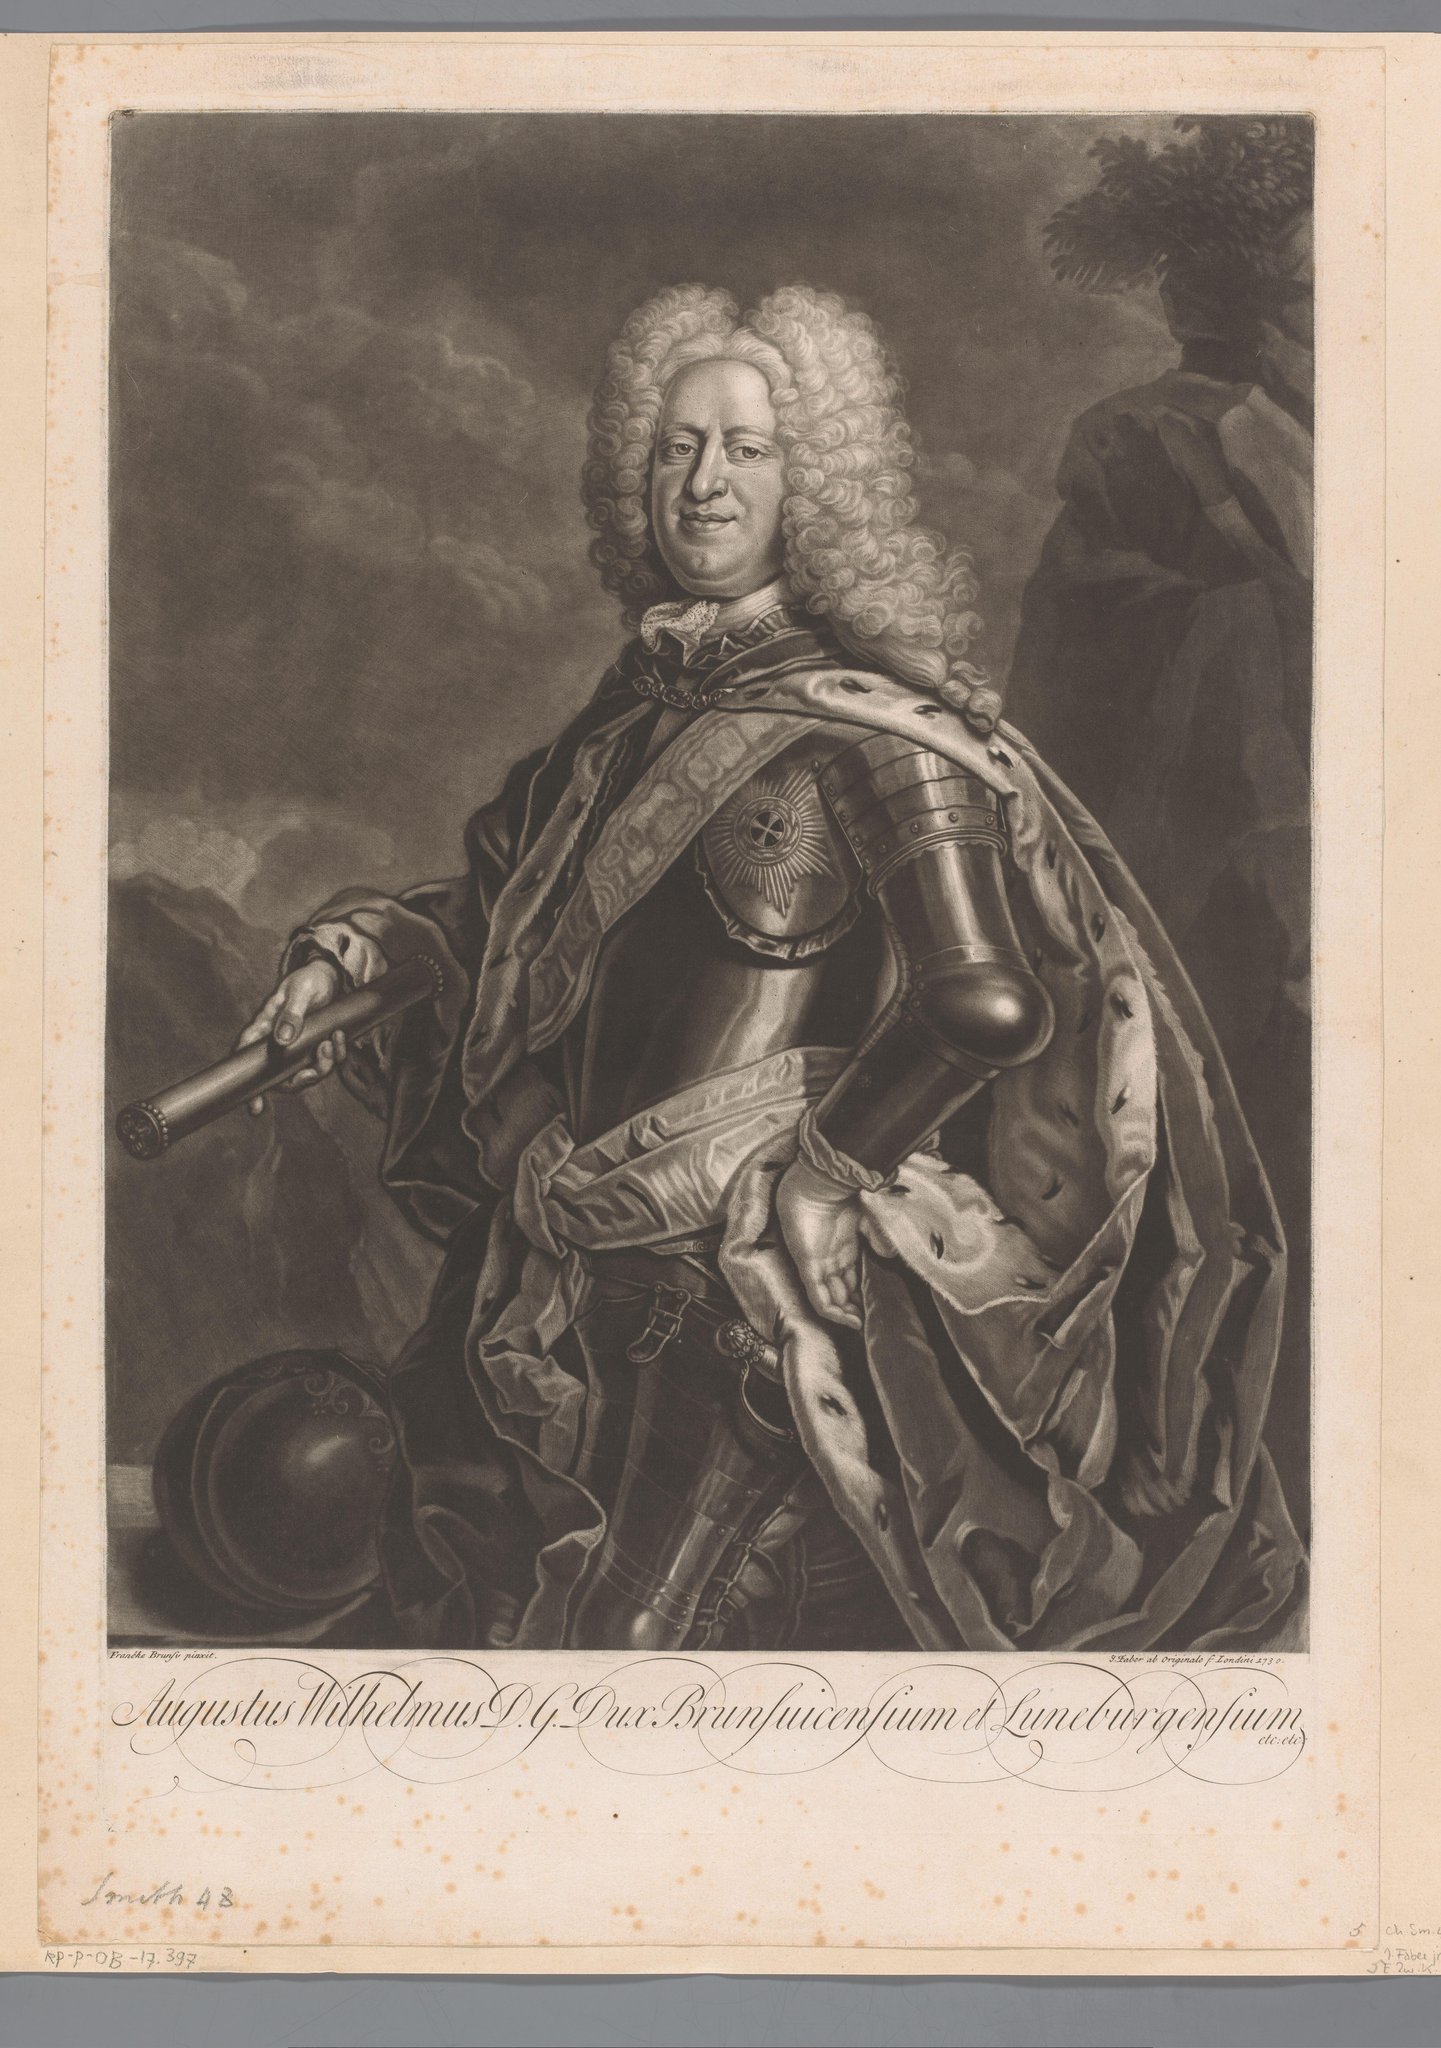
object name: print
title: Portret van August Wilhelm von Braunschweig-Lüneburg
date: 1730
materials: paper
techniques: mezzotint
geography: london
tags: commander-in-chief, general, marshal, historical persons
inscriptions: collector's mark: Lugt 240